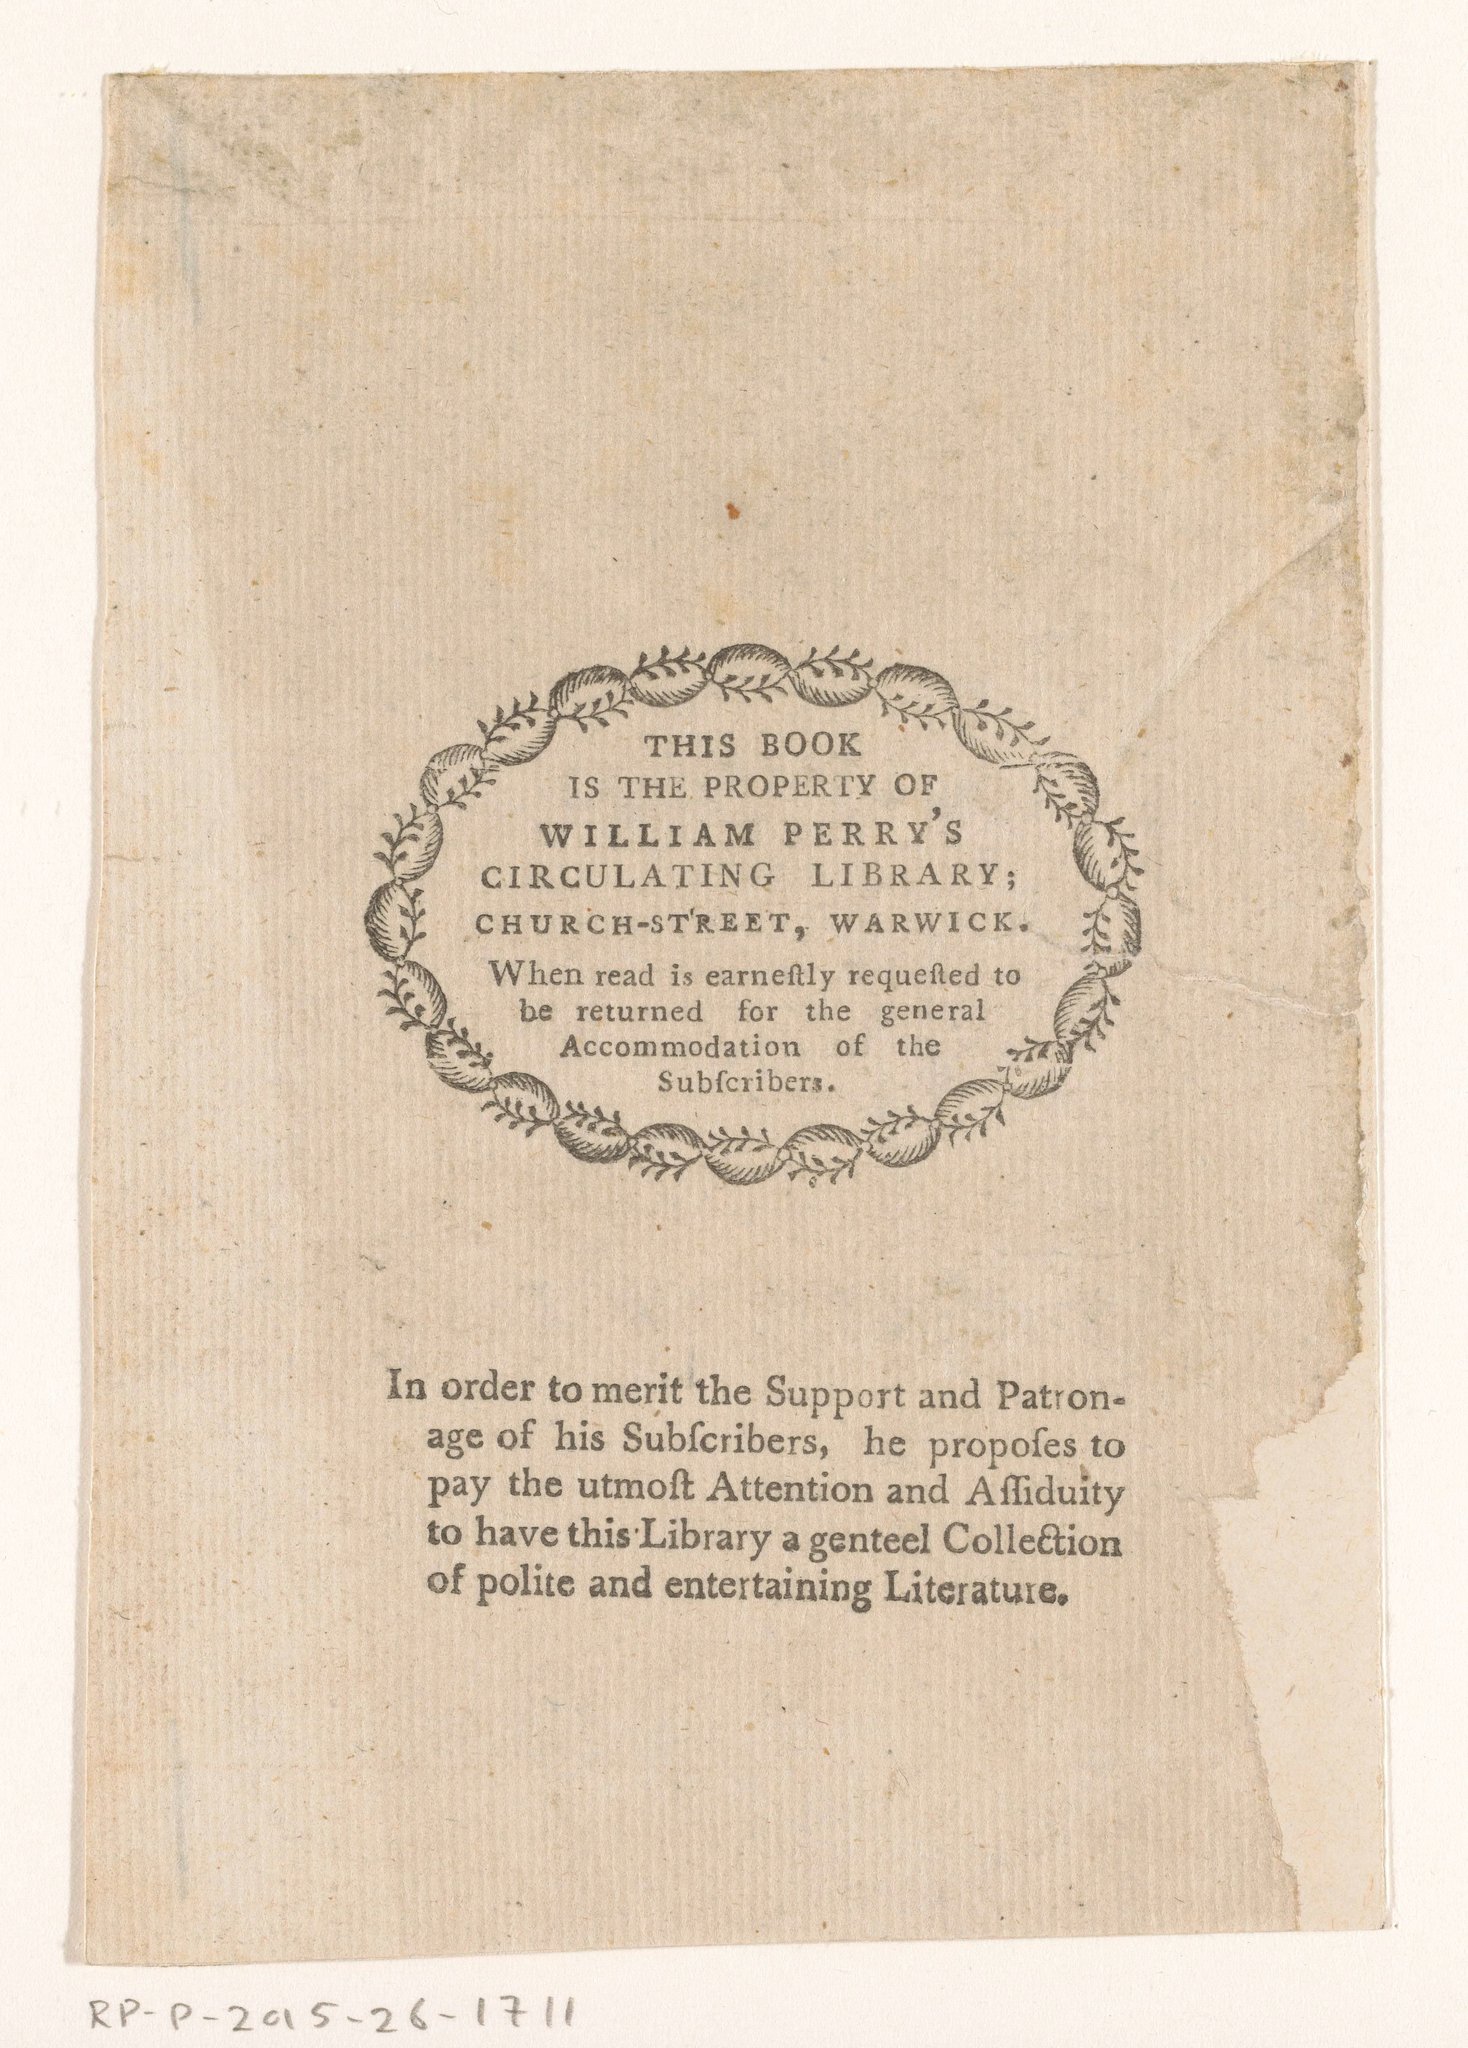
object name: bookplate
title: Ex libris van William Perry's Circulating Library te Warwick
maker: Anonymous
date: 1815-1864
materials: paper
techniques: letterpress printing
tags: warwick